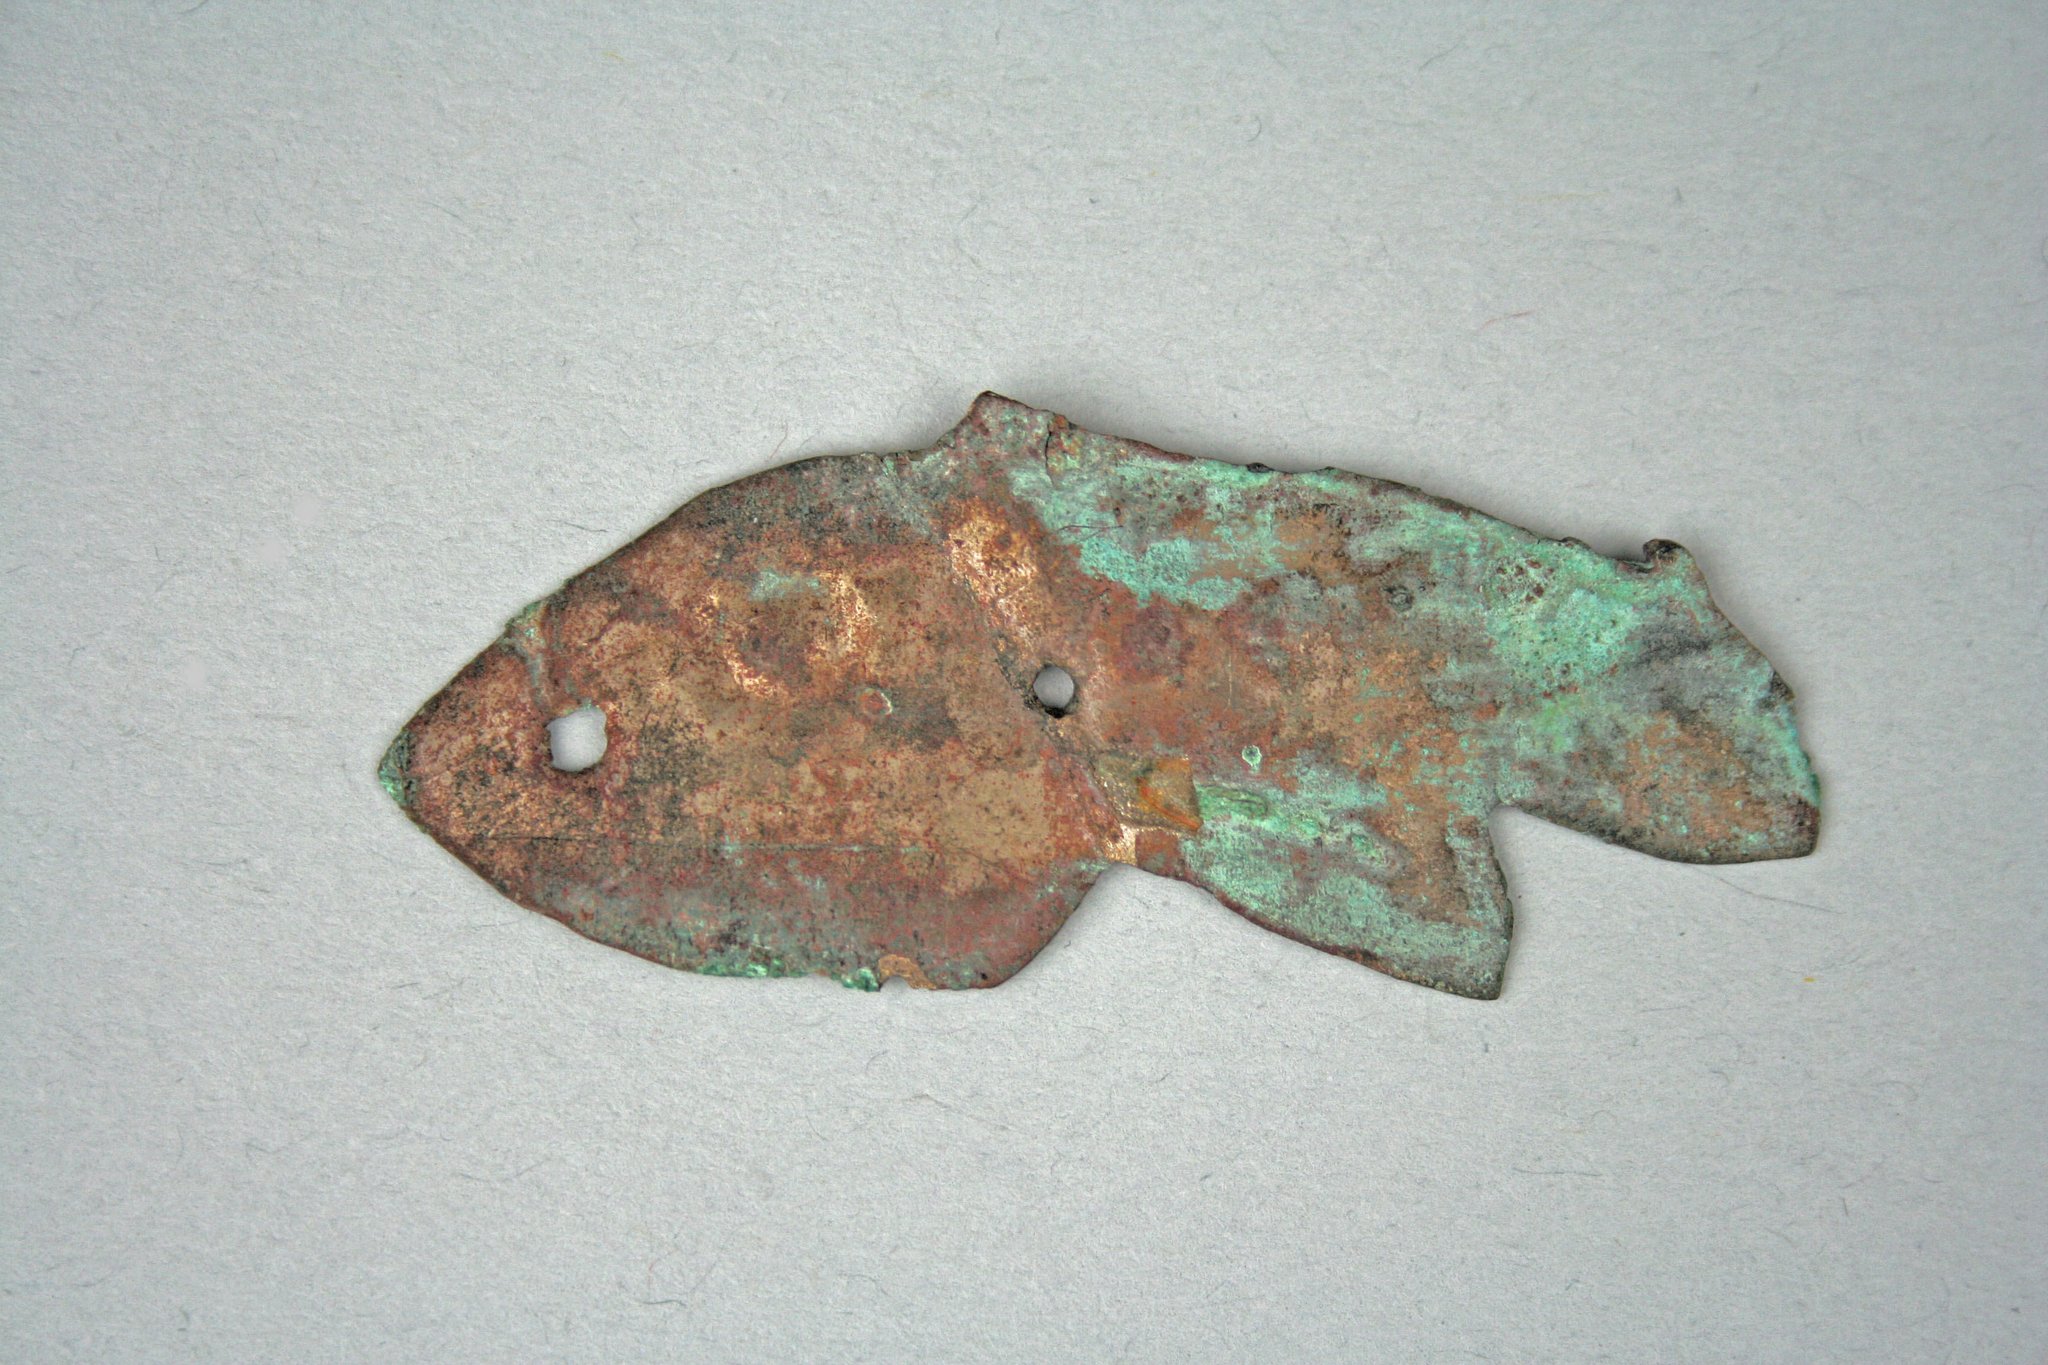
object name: ornament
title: Fish Ornament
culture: peruvian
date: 1001-1200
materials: silver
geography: peru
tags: fish